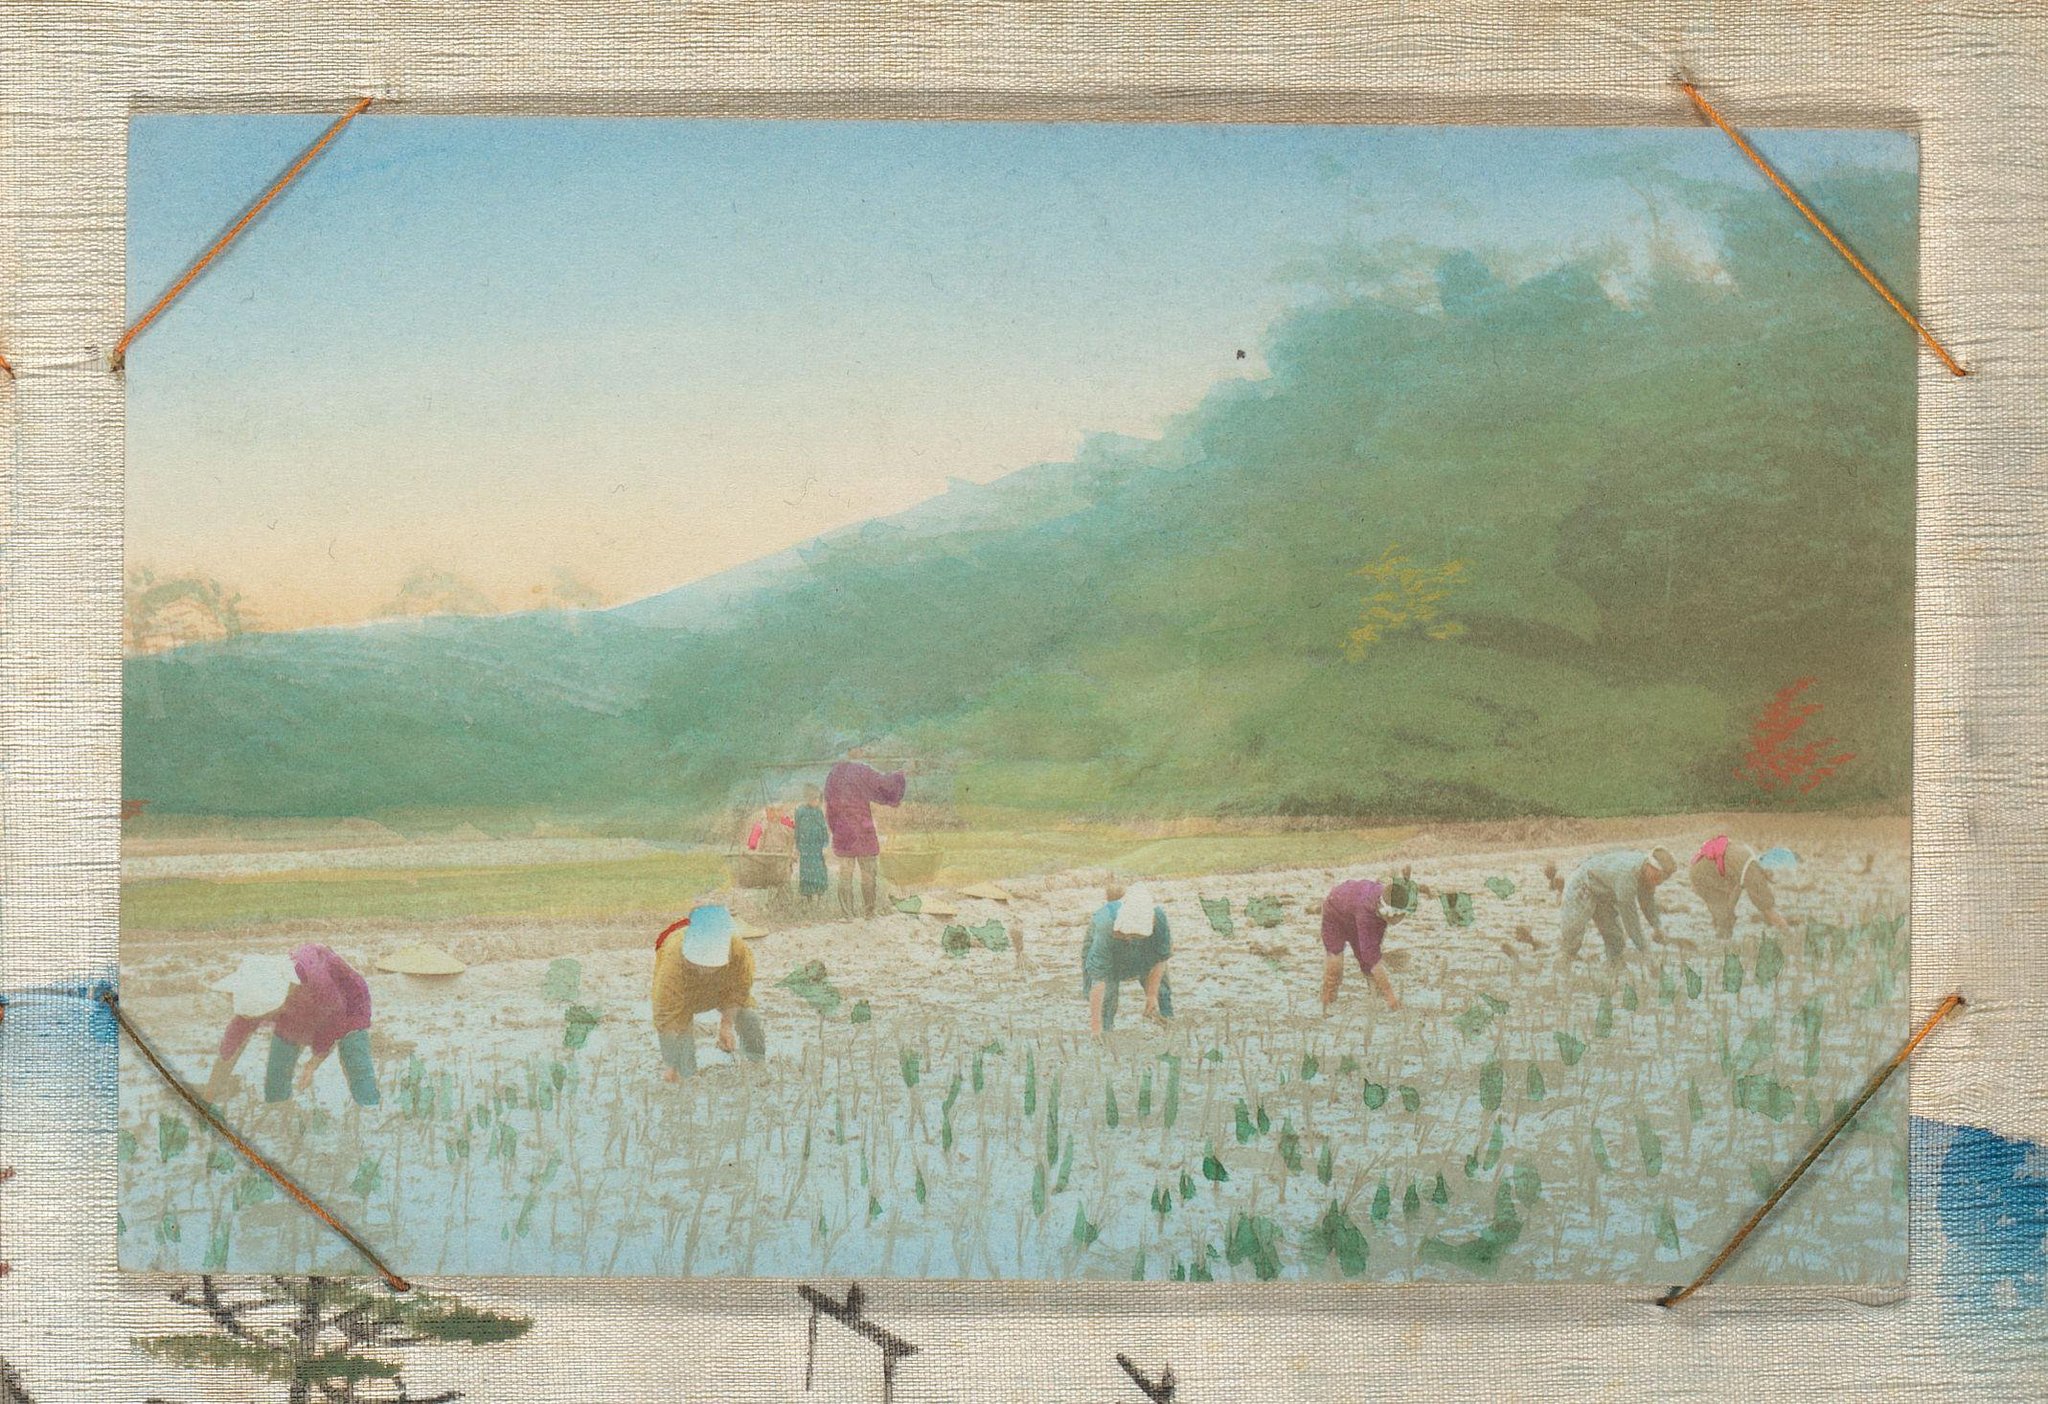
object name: photograph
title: Mensen aan het werk op een rijstveld, Japan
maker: Anonymous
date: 1900-1920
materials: photographic support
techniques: hand coloring, salted paper print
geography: japan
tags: sawahs, rice paddies